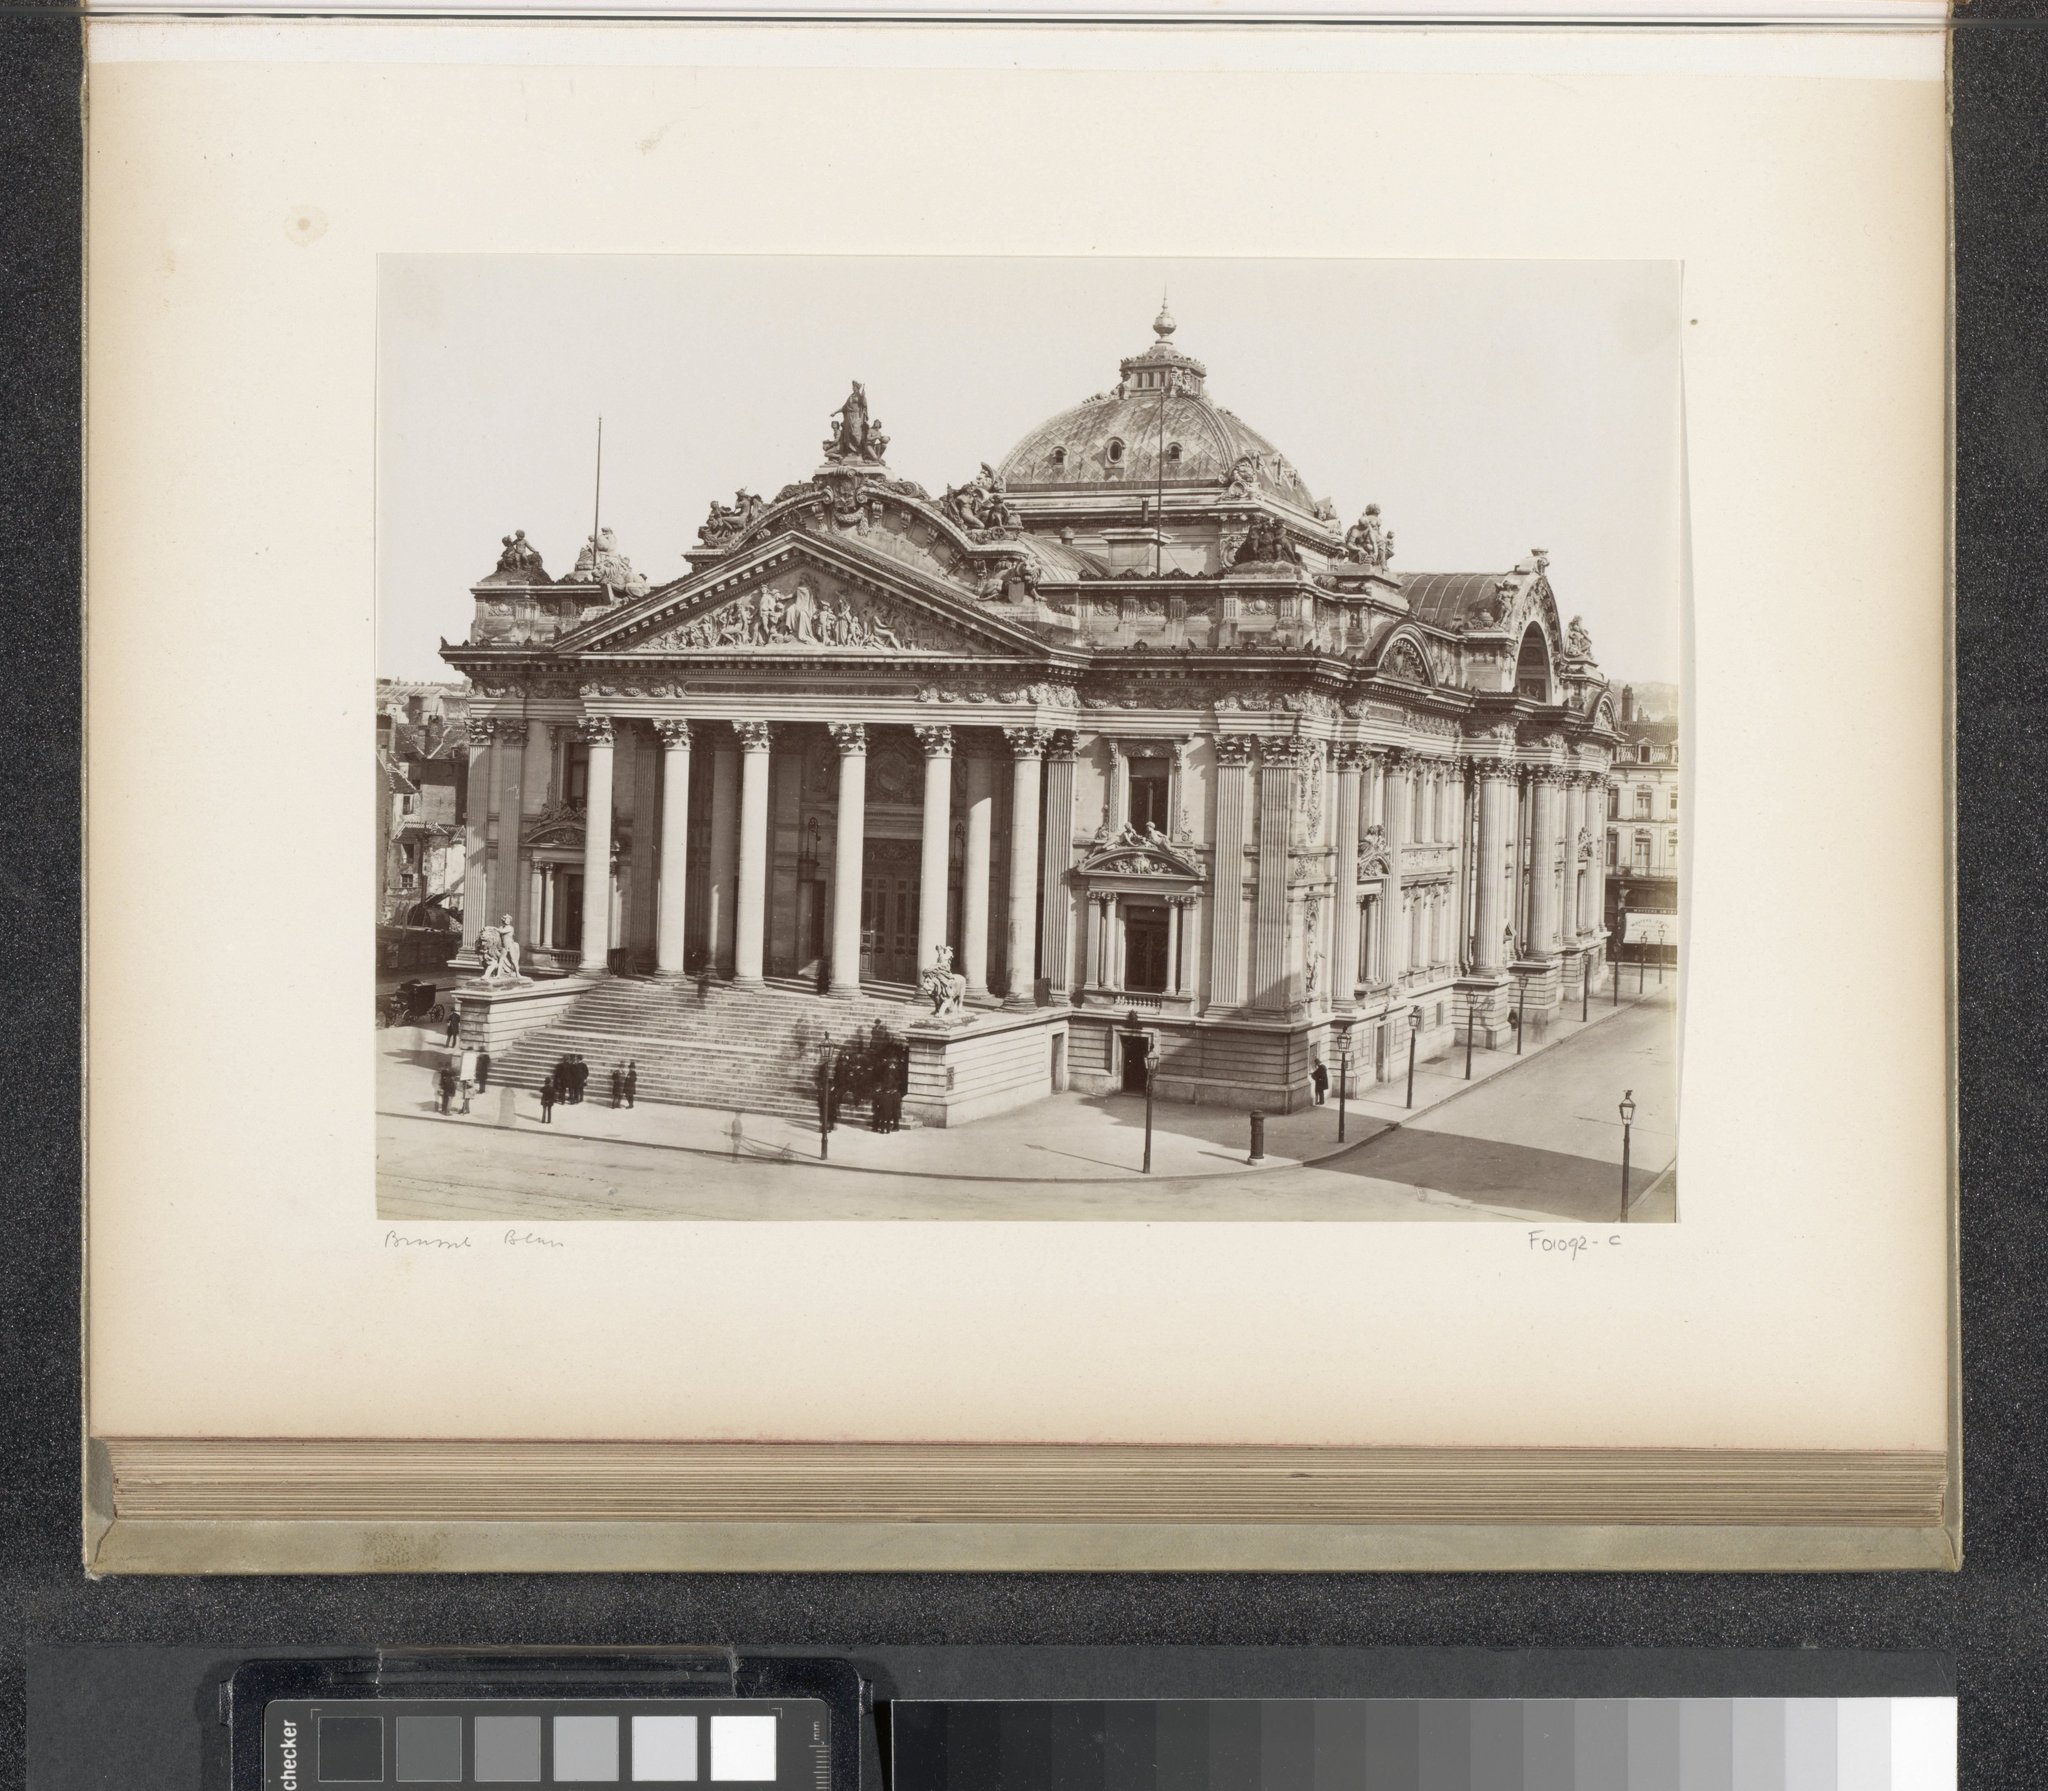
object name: photograph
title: Exterieur van de beurs van Brussel, gezien vanaf de Anspachlaan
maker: Anonymous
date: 1880-1900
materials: cardboard, paper, photographic support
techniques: albumen print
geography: brussels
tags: stock exchange, stock-market, exterior ~ representation of a building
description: Onderdeel van Reisalbum met foto's van bezienswaardigheden in België en Frankrijk.